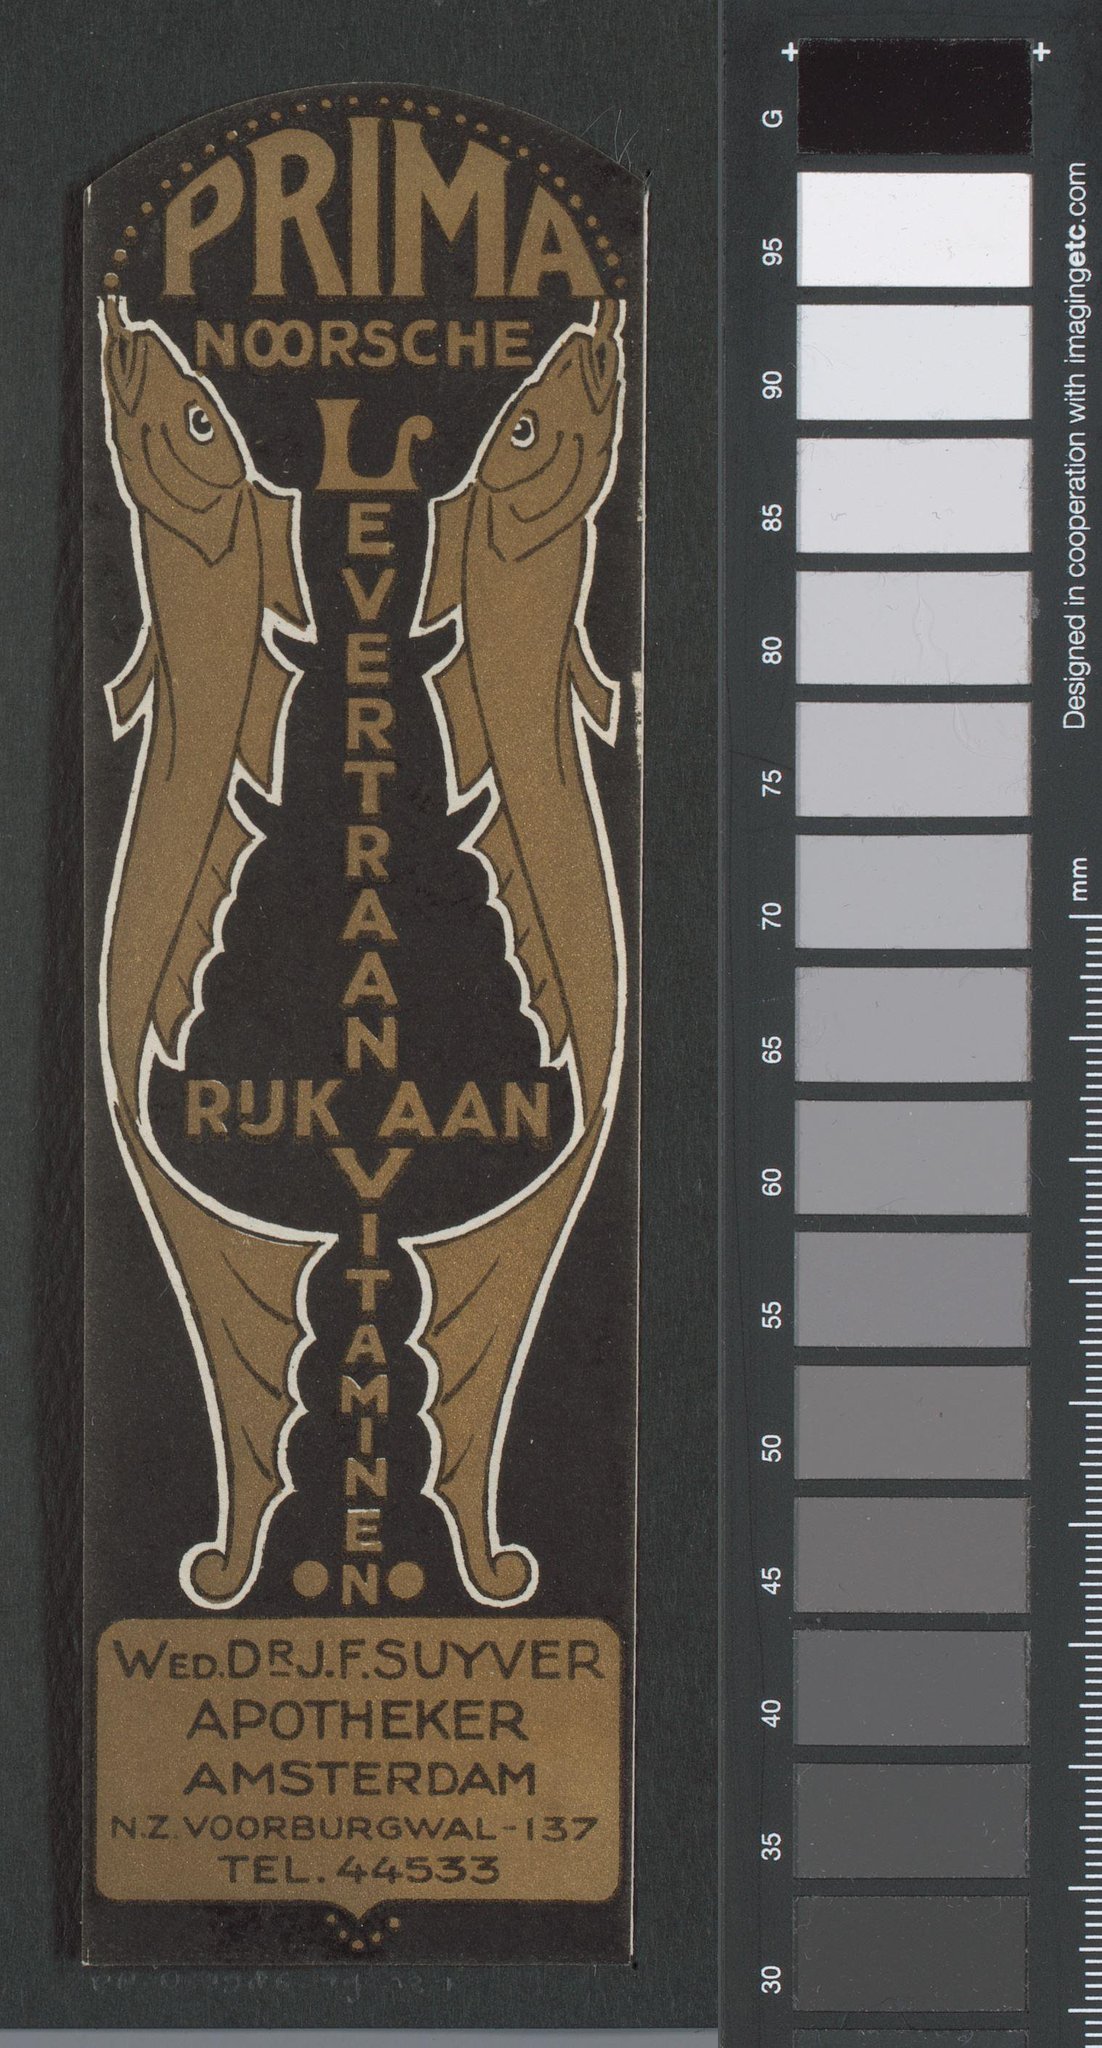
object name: drawing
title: Ontwerp voor een apothekersetiket voor levertraanemulsie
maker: reinier willem petrus de vries (1874-1953)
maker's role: draughtsman, print maker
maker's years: 1874-1953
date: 1884-1952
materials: paper, pencil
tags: fishes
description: Ontwerp met een vis en de woorden 'levertraan' en 'emulsie'.